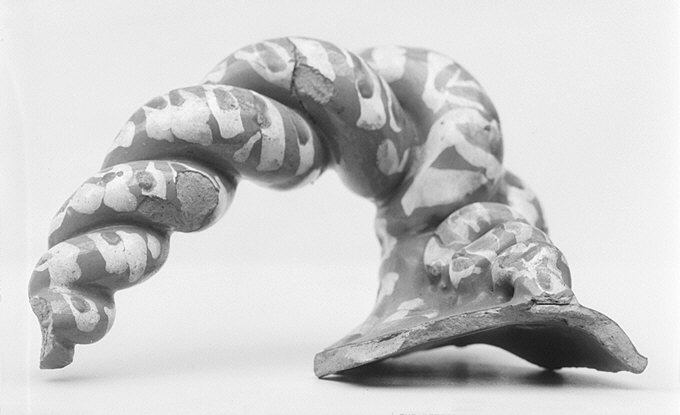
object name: fragment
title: Fragment (part of a set)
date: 1670-1680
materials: faience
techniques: glazing